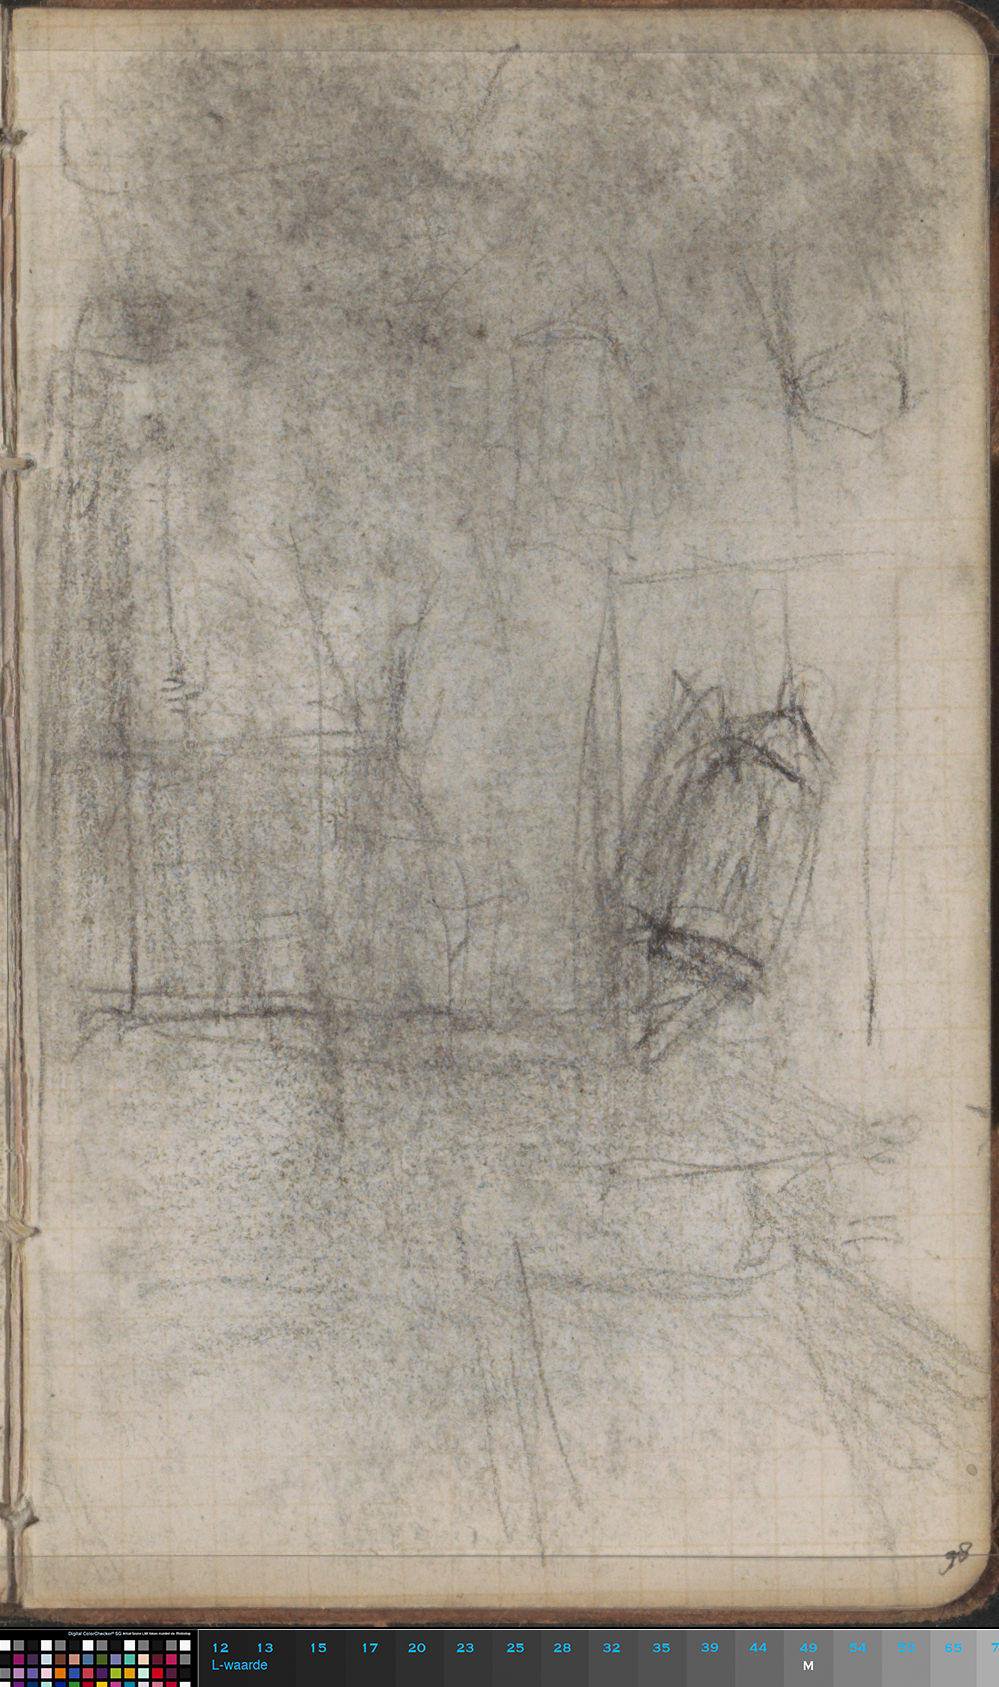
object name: sketchbook leaf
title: Studie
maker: marius bauer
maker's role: draughtsman, print maker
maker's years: 1867-1932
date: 1879-1885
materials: chalk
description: Pagina 98 uit een schetsboek met 58 bladen.